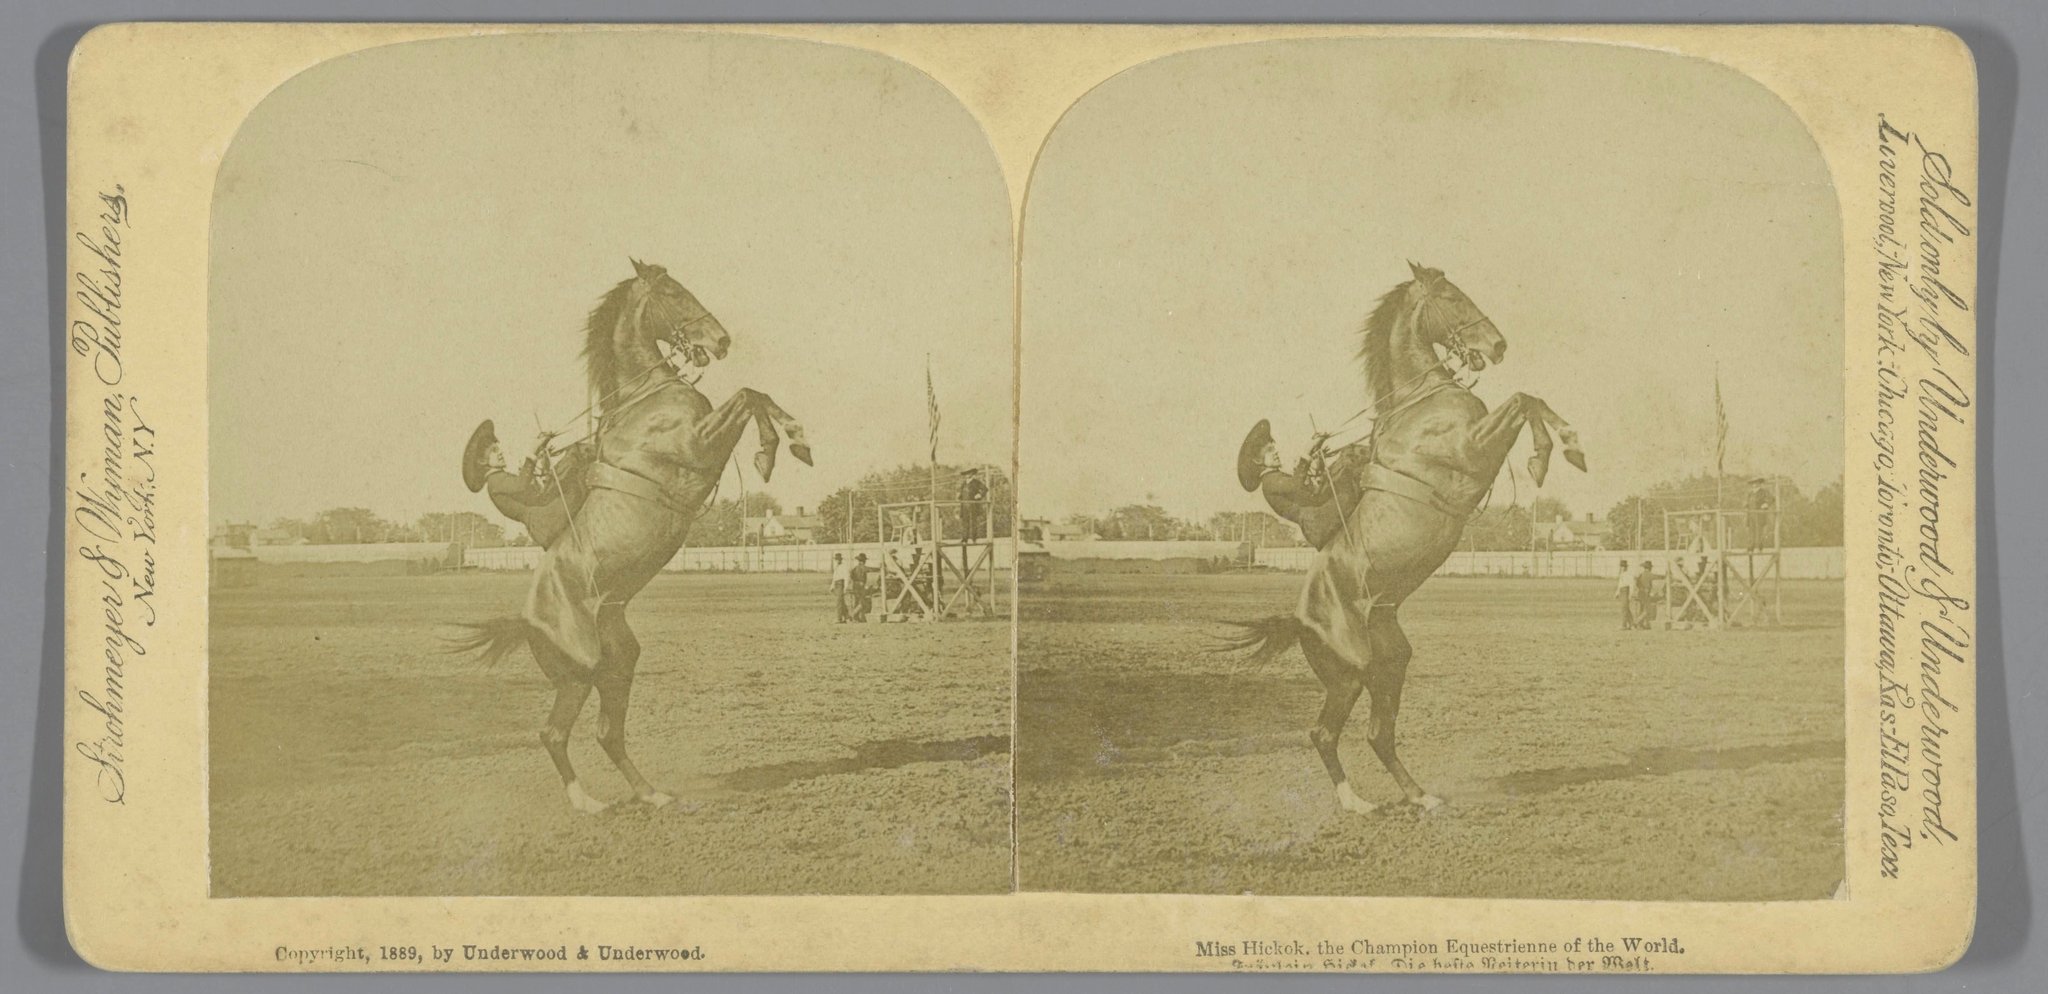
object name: stereograph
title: Emma Lake op een steigerend paard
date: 1889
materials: cardboard, photographic support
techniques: albumen print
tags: horse-racing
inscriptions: company name: ‘Strohmeyer & Wyman Publishers / New York, NY’, company name: ‘Sold only by Underwood & Underwood, Liverpool, New York, Chicago, Toronto, Ottawa, Kas. El Paso, Tex.’, : ‘Copyright, 1889, by Underwood & Underwood’